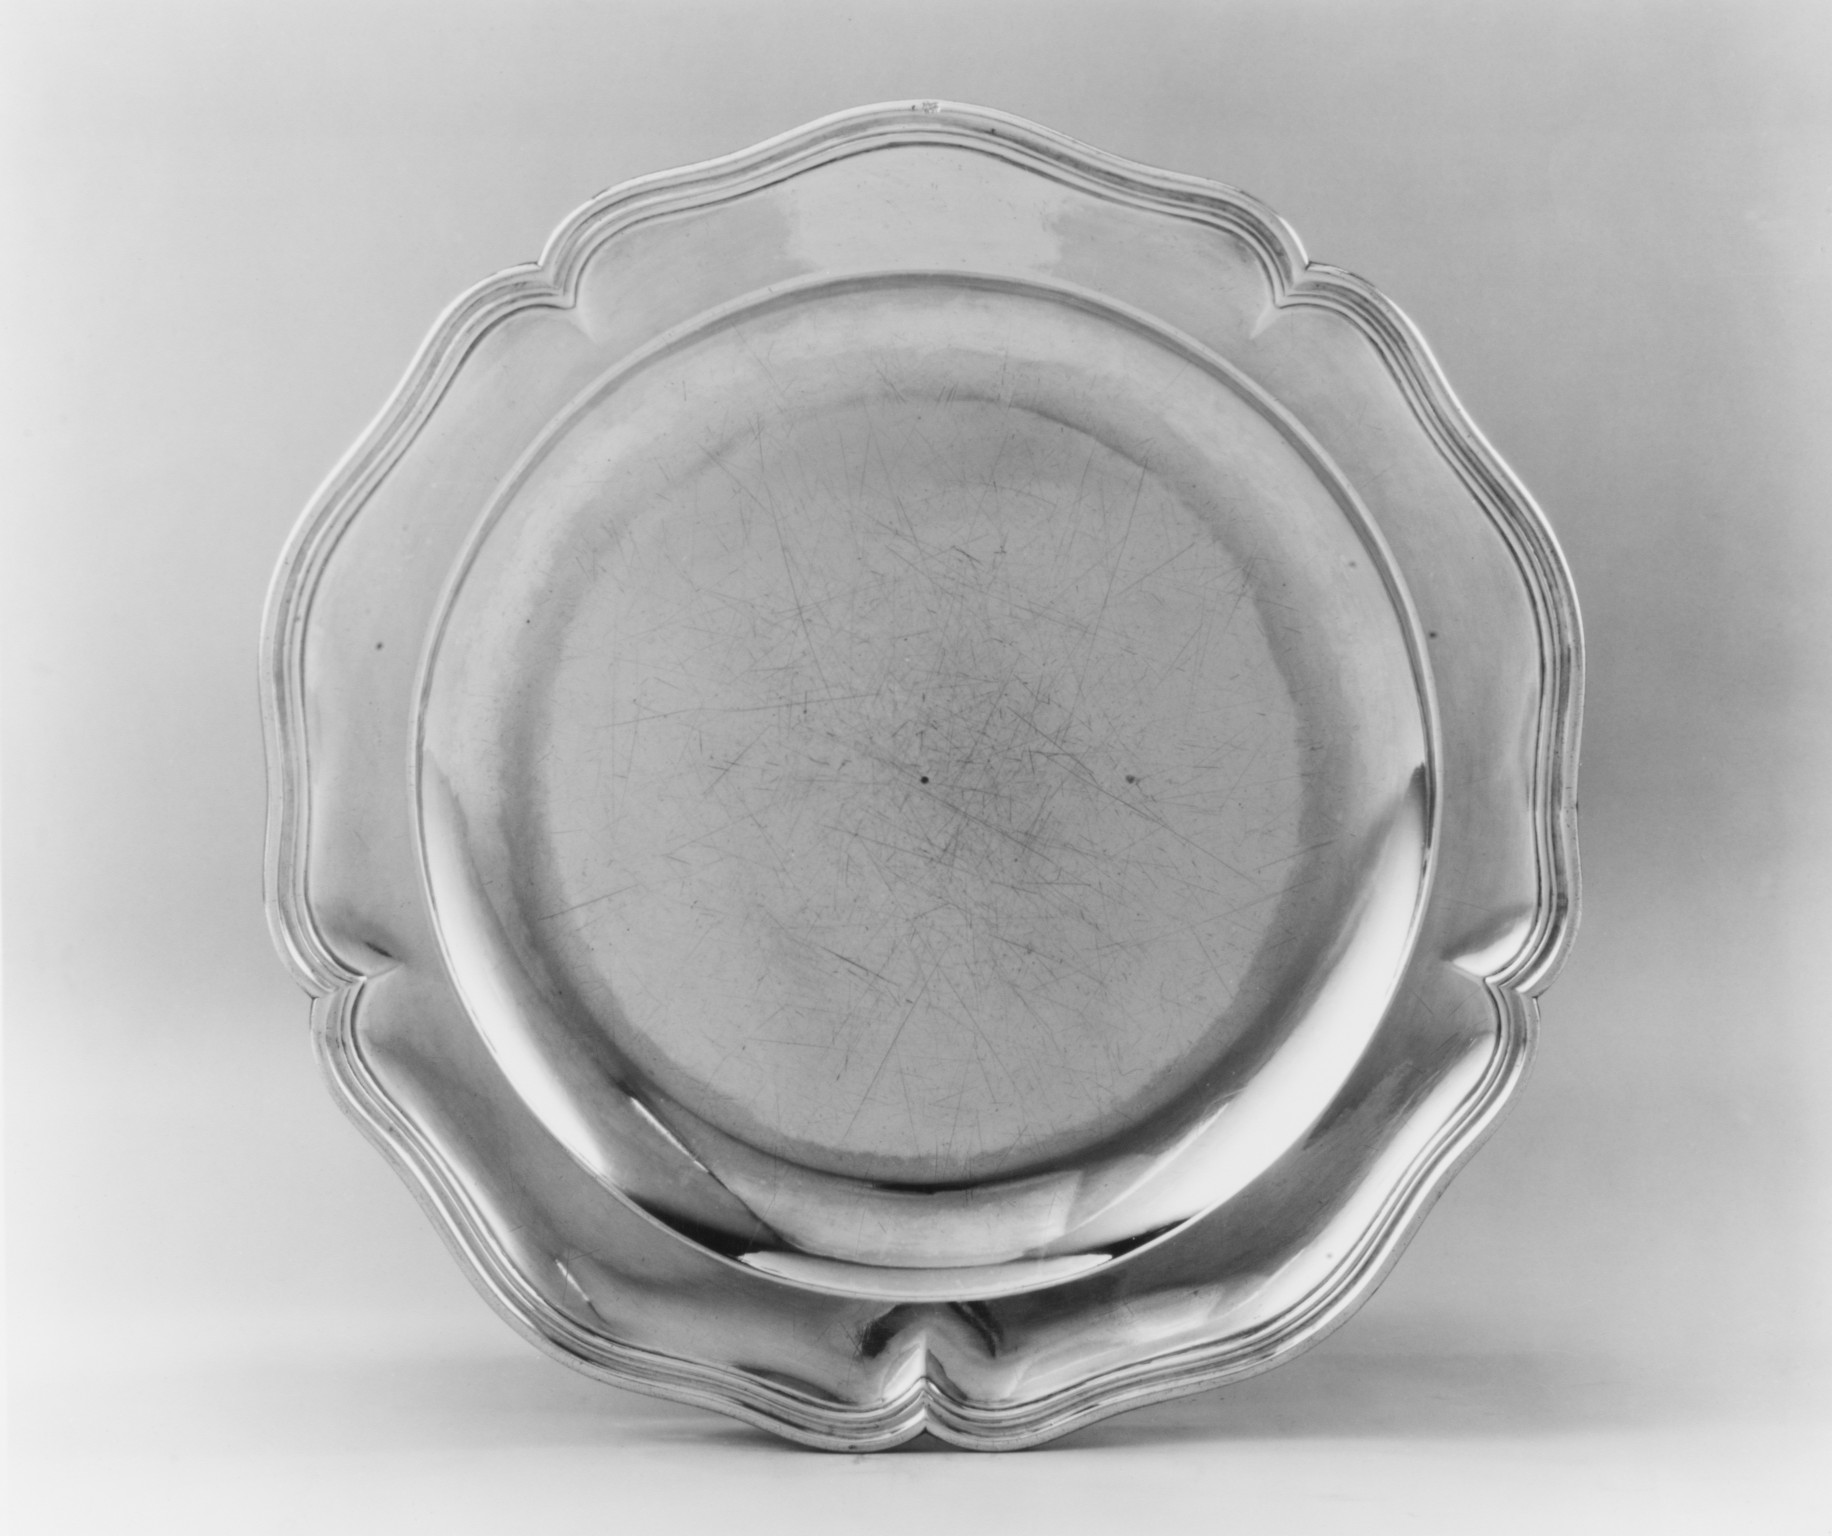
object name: plate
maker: jean jambin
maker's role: maker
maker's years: 1690-1772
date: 1732-1738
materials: silver